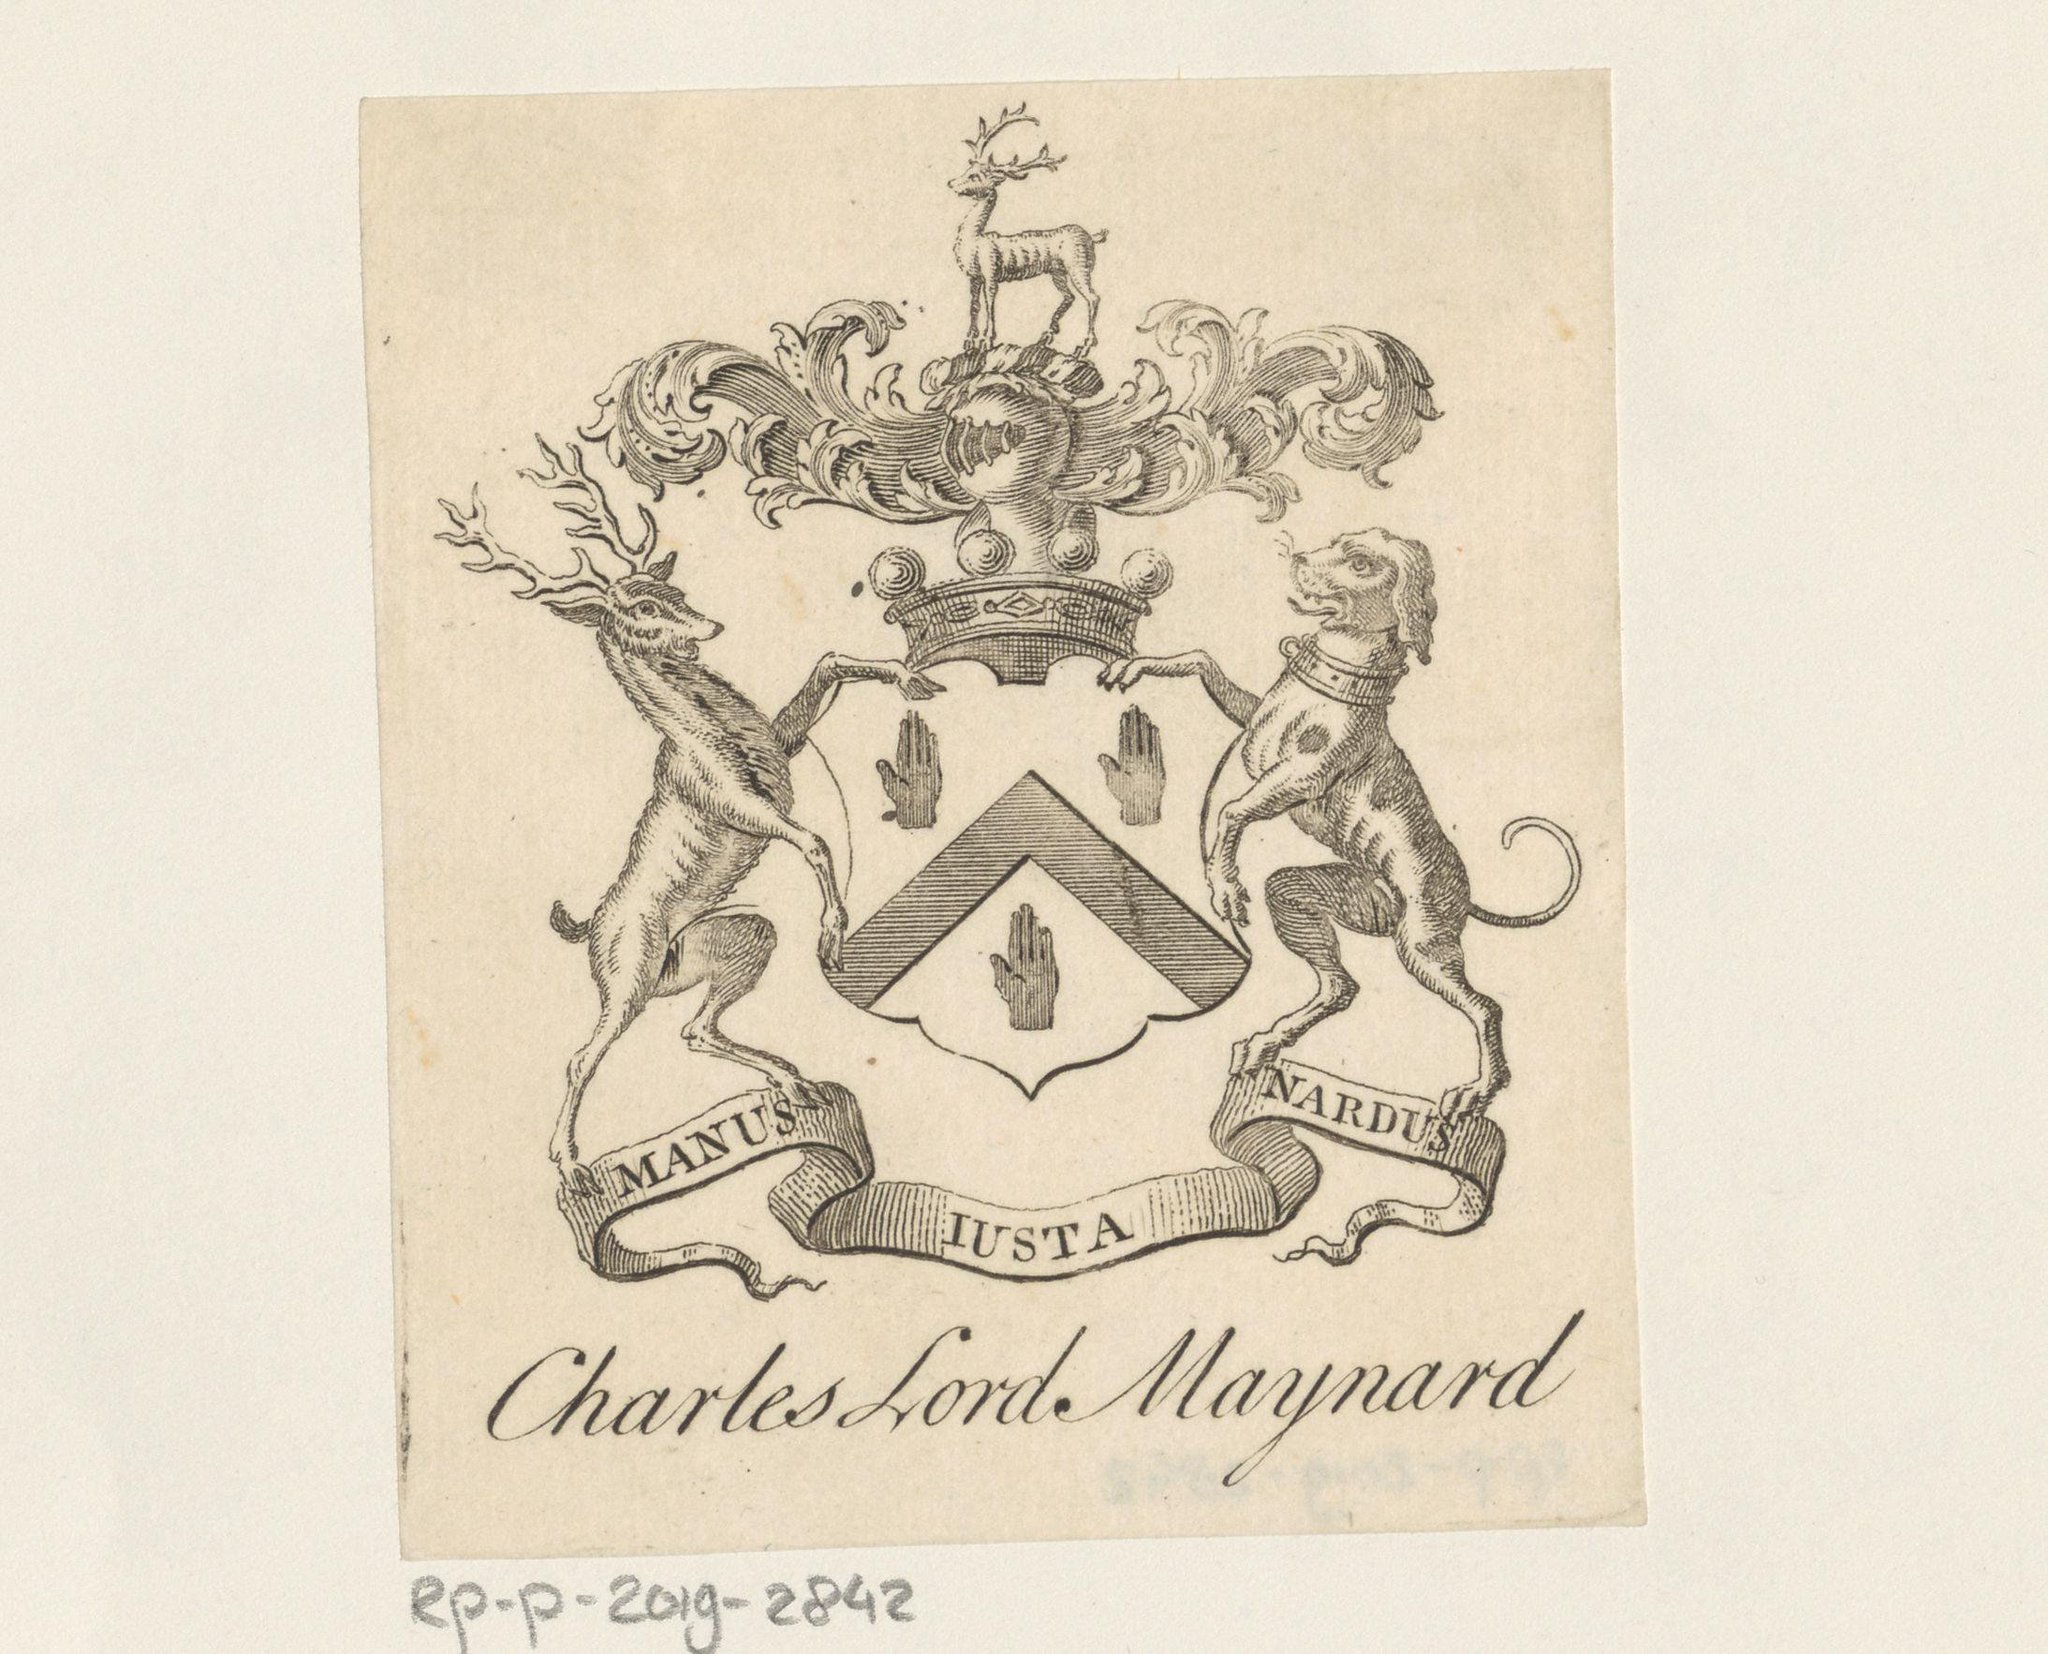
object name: bookplate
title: Ex libris van Charles Lord Maynard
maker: Anonymous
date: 1700-1775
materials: paper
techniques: engraving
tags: armorial bearing, heraldry